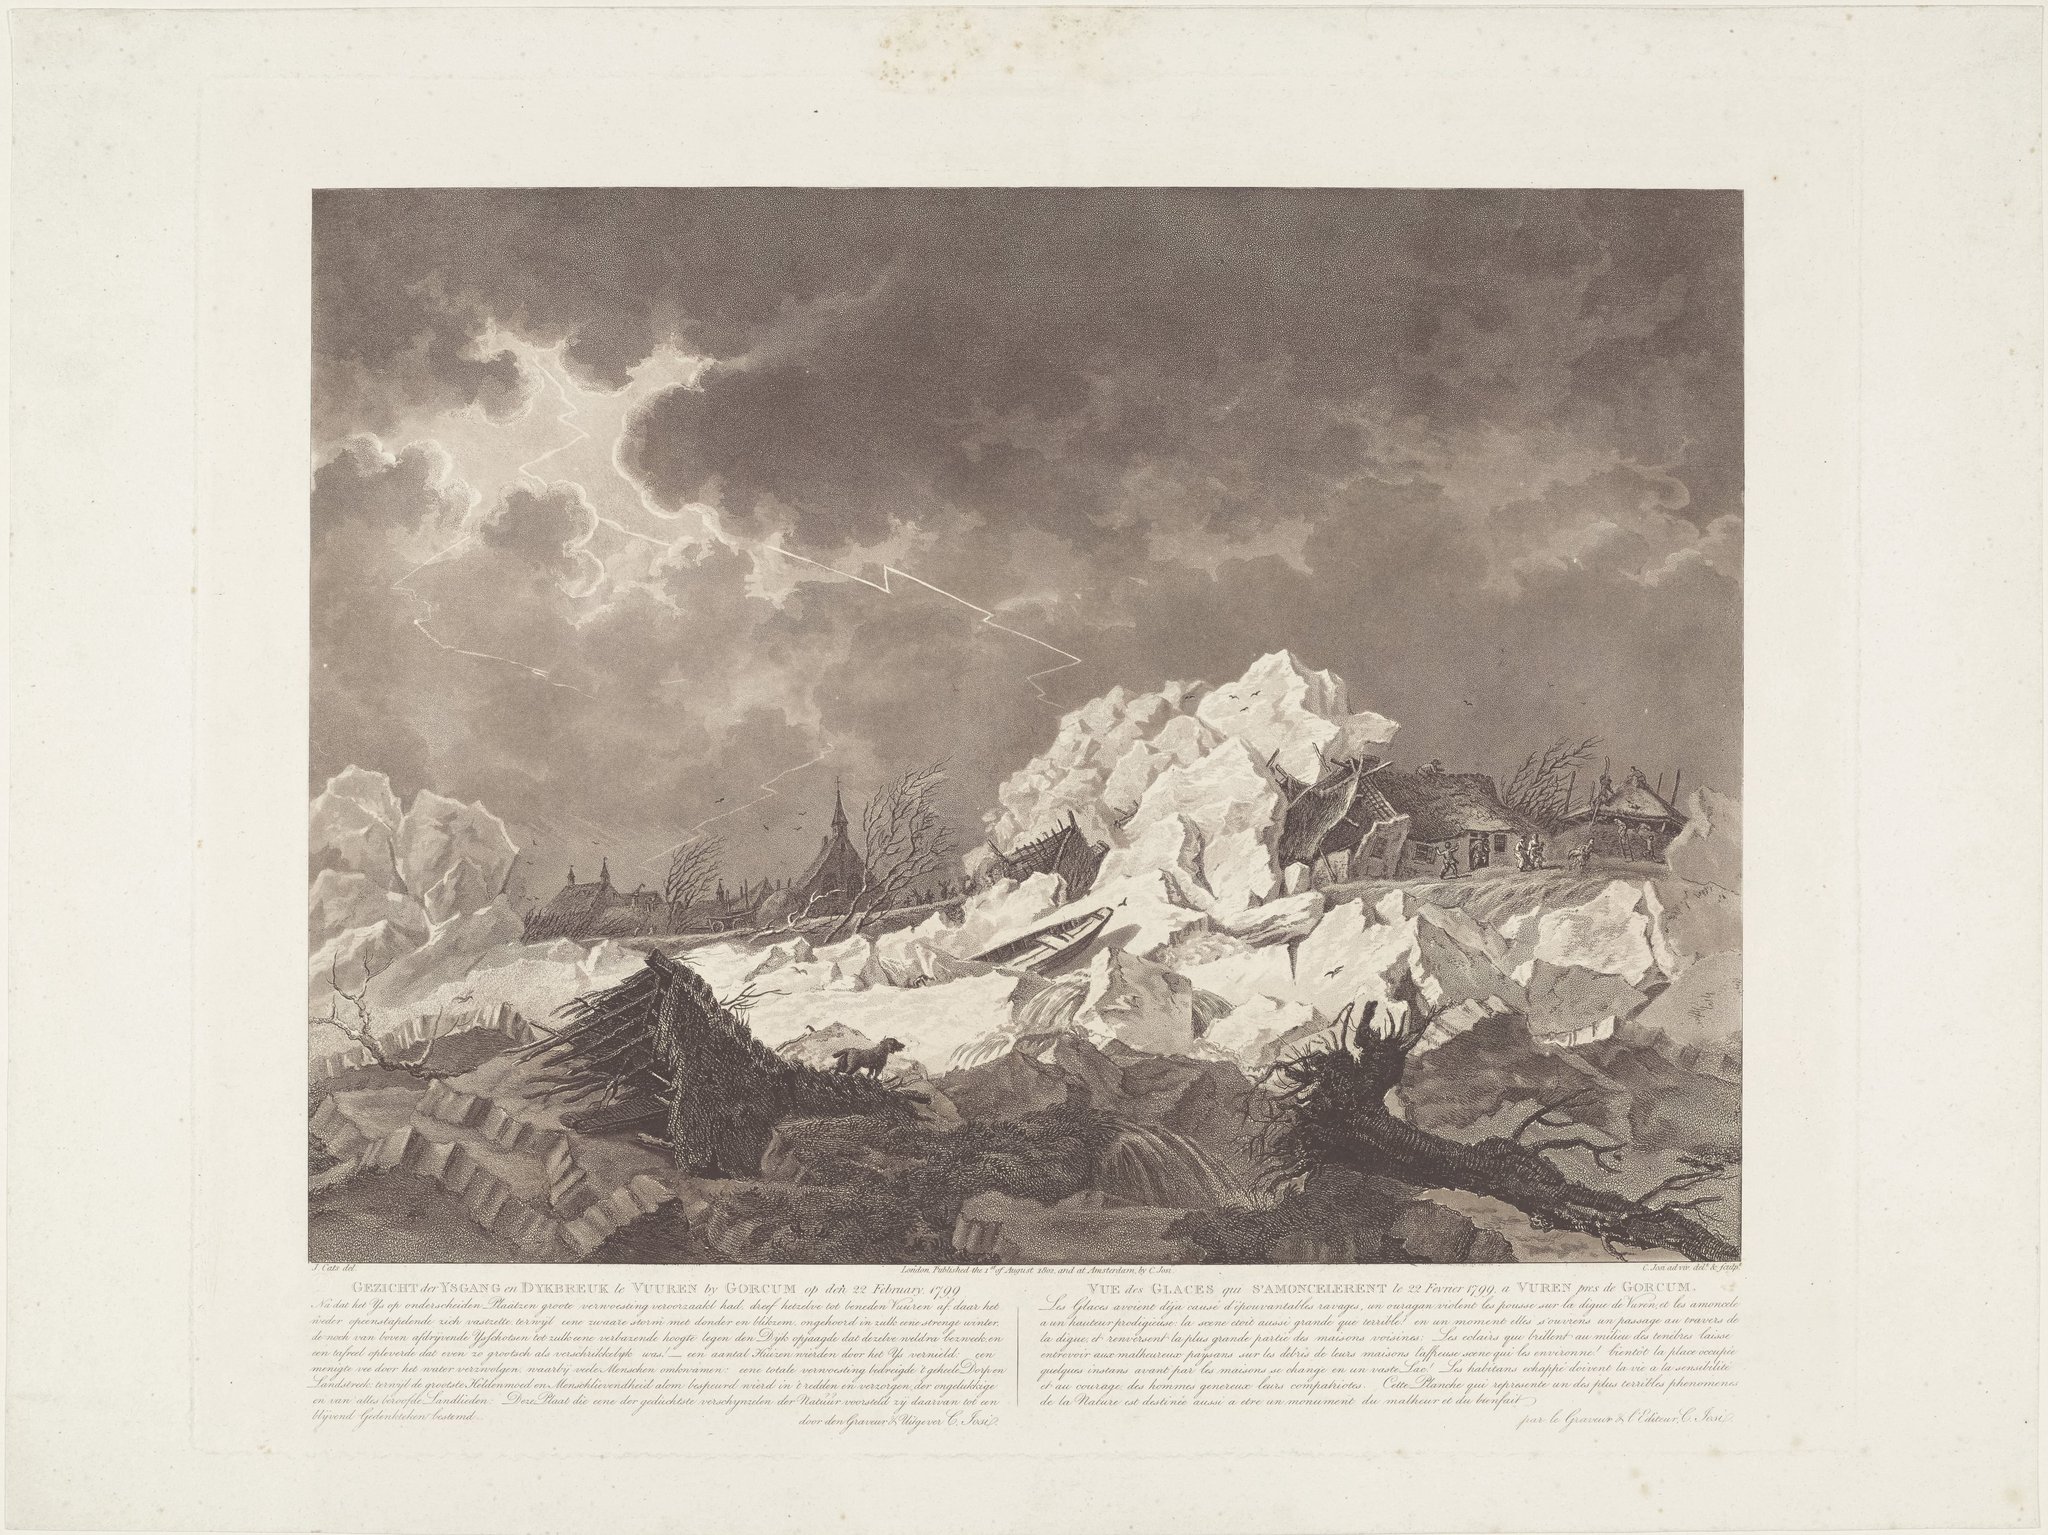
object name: print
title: Gezicht der Ysgang en Dykbreuk te Vuuren by Gorcum op den 22 February 1799 / Vue des Glaces qui S'Amoncelerent le 22 Fevrier 1799, a Vuren pres de Gorcum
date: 1802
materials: paper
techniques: aquatint, etching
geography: london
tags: dike-break, drift ice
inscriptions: collector's mark: Lugt 2228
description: Ophoping van ijsschotsen in de rivier de Merwede te Vuren bij Gorinchem, 22 februari 1799. Rechts een boerderij dat door de ijsberg wordt verdrukt. Zie ook de pendant.